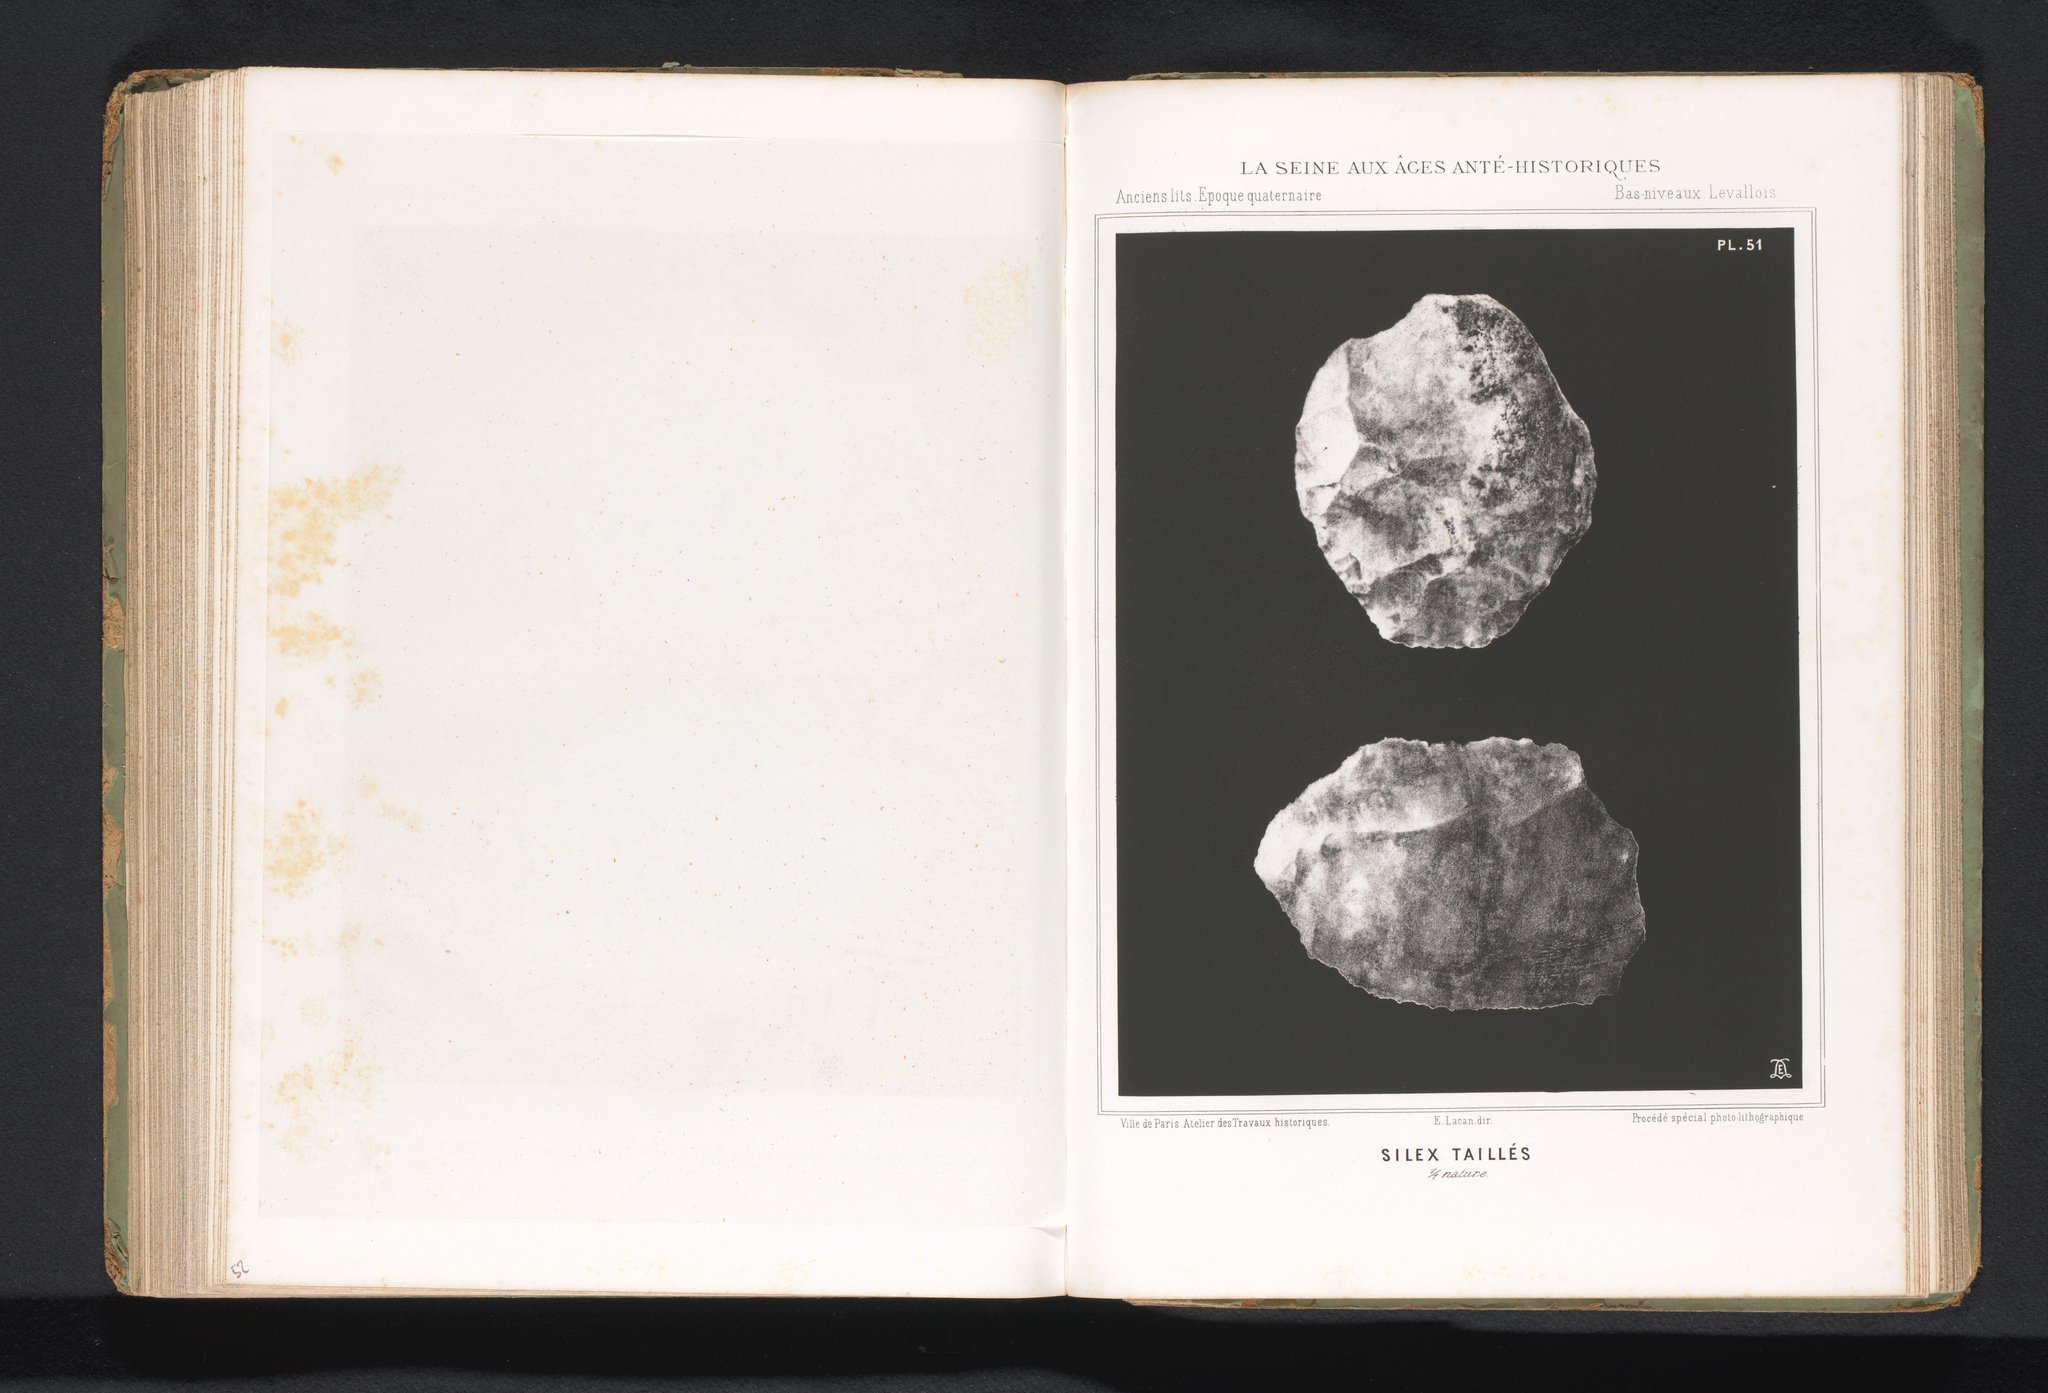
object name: photomechanical print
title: Instrumenten van vuursteen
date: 1864-1869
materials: paper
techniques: photolithography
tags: tools, aids, implements ~ crafts and industries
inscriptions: inscription: ‘Procédé spécial photo-lithographique’, inscription: ‘PL. 51’, inscription: ‘1/1 nature’, monogram: ‘EL’